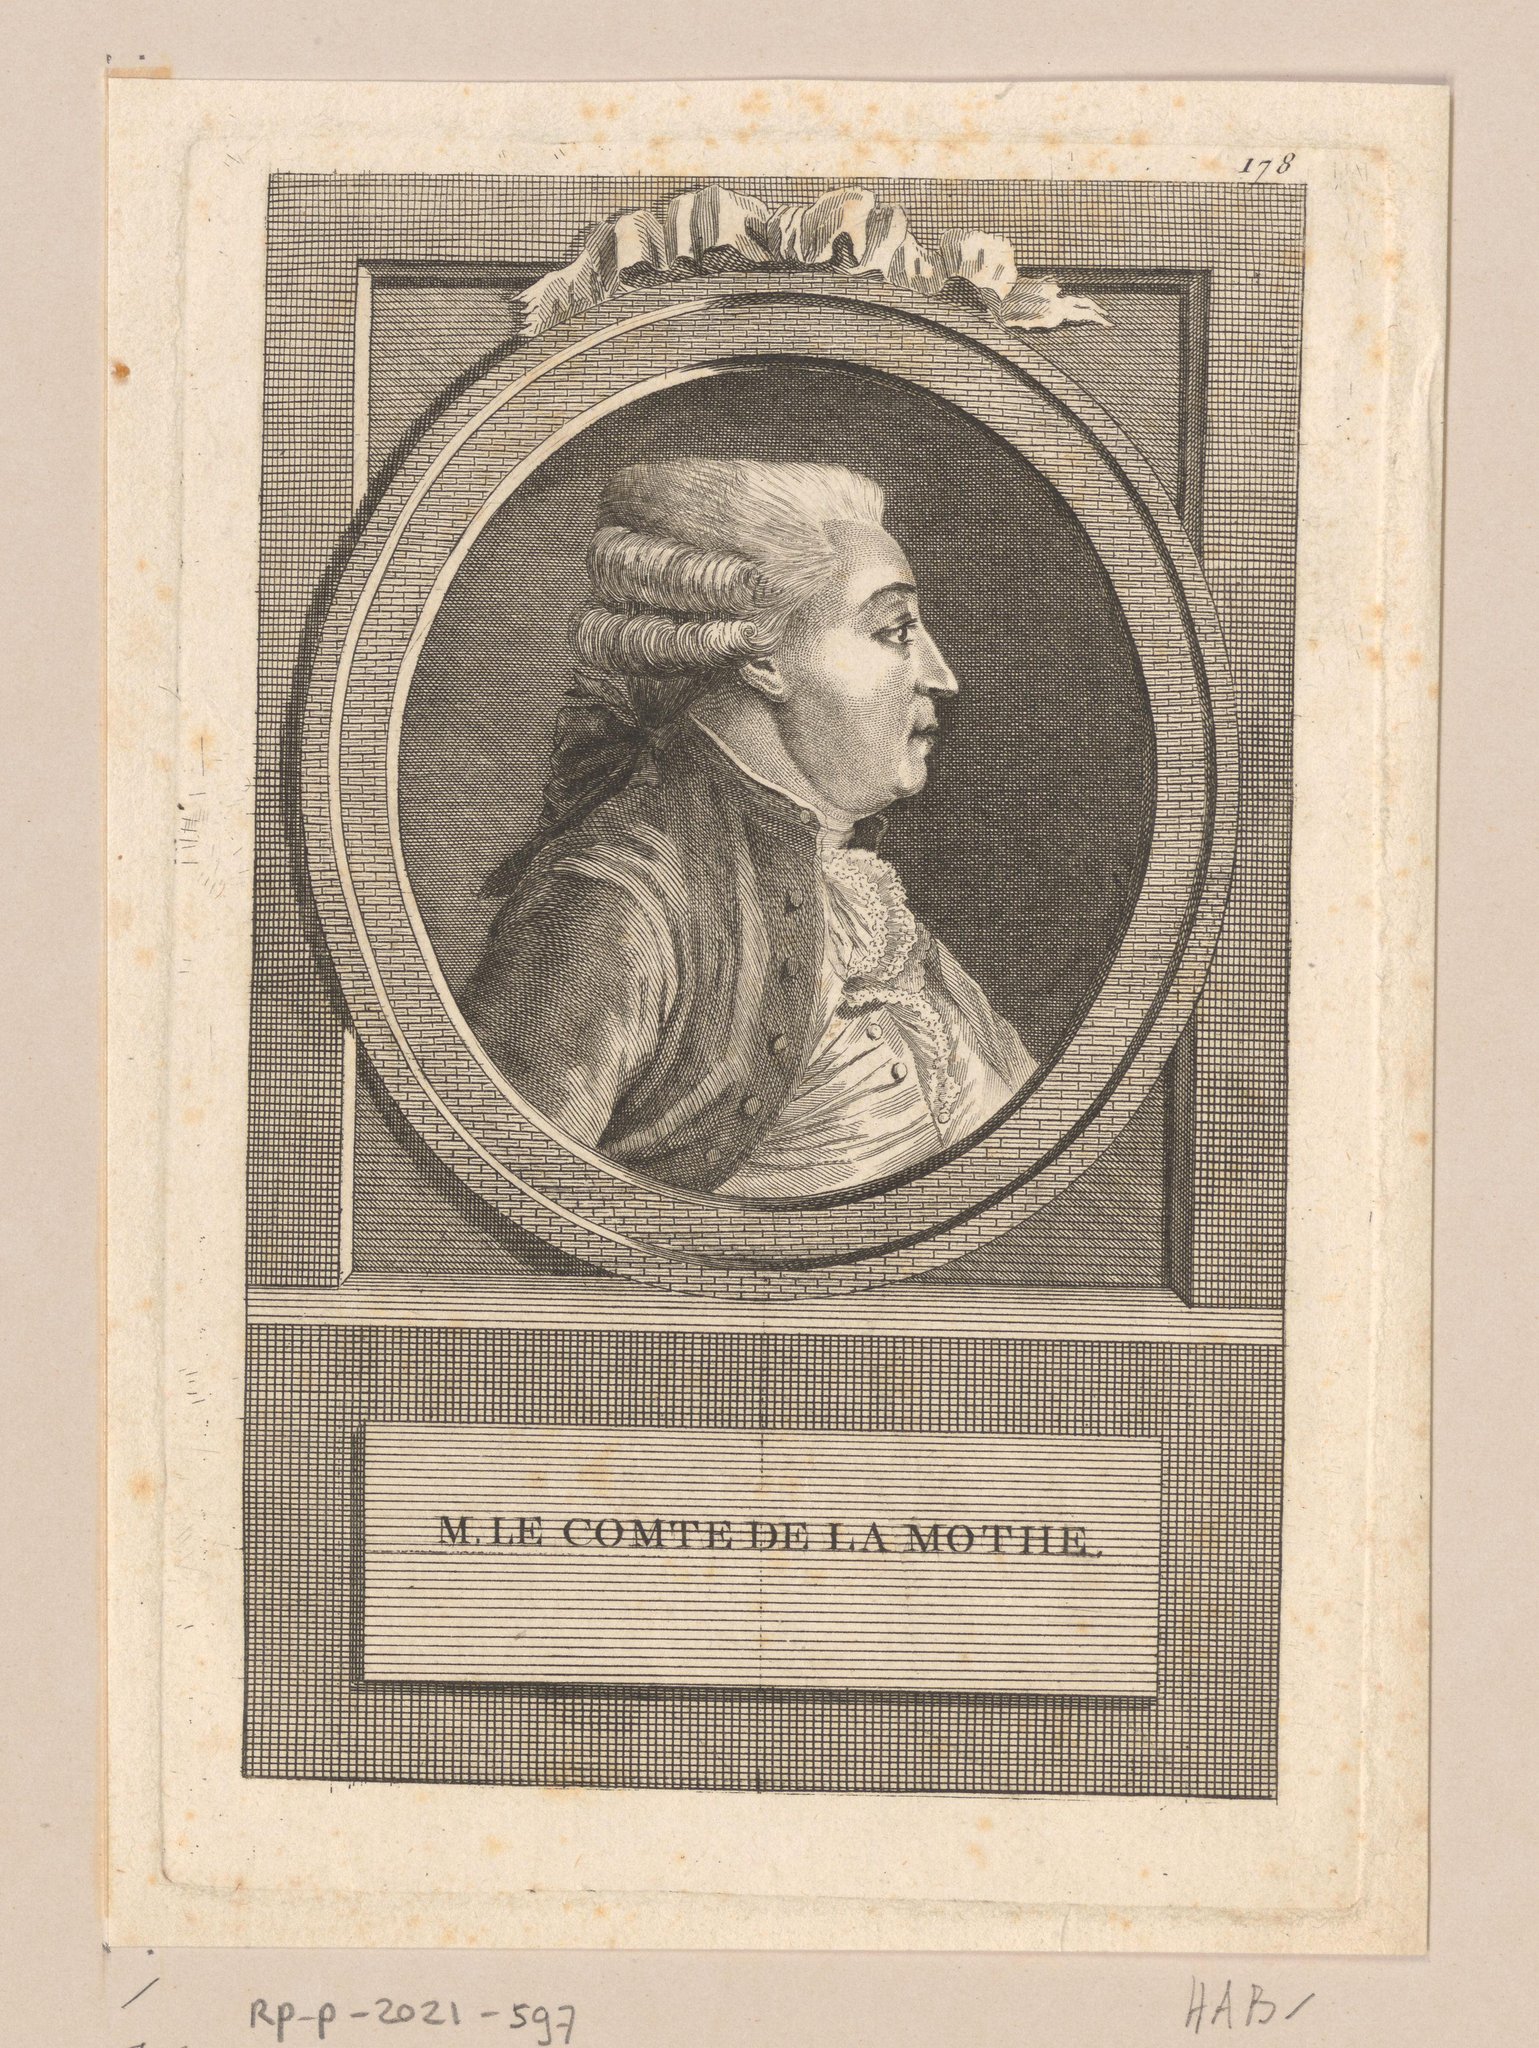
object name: print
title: Portret van Nicolas de La Motte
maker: Anonymous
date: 1780-1799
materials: paper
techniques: etching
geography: france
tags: paris, ornament ~ medallion, historical persons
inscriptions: inscription: ‘Coll. Drugulin/ port 55.’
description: Rechtsboven genummerd: 178. Portret van 'Comte de La Mothe', vermoedelijk Nicolas de La Motte.